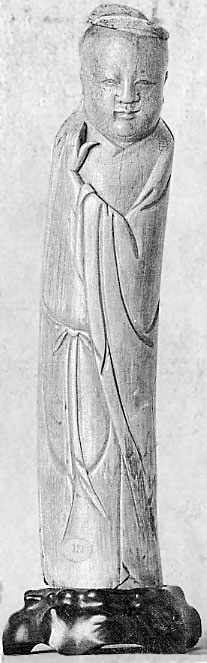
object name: figure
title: Carved Figure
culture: chinese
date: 1701-1800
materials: ivory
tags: men